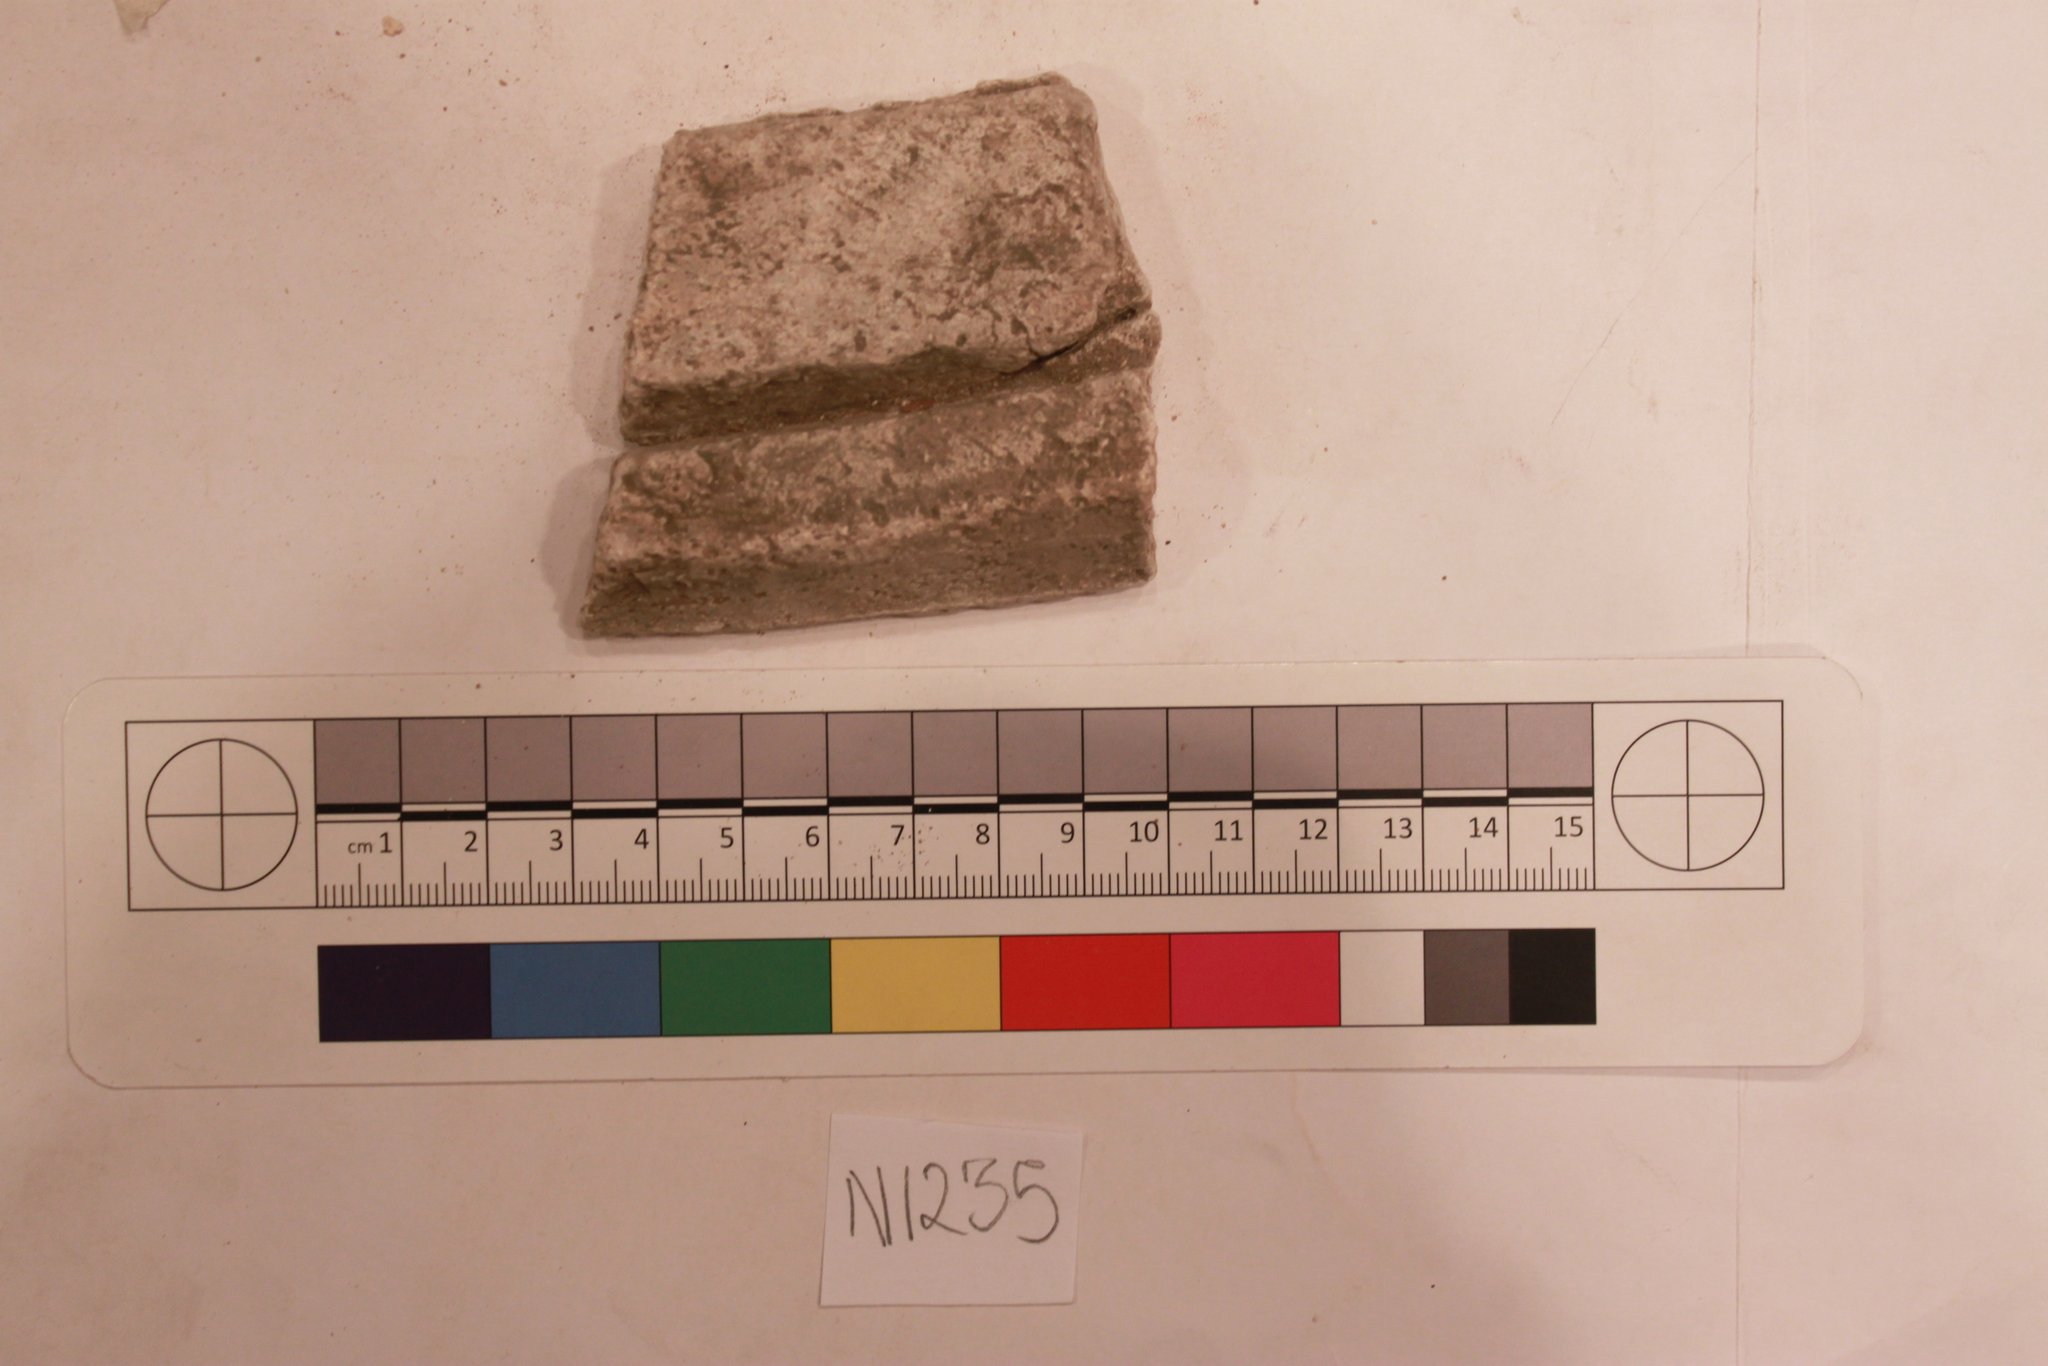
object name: fragment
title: Stucco Fragment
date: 701-1200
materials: plaster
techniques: carving, painting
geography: iran